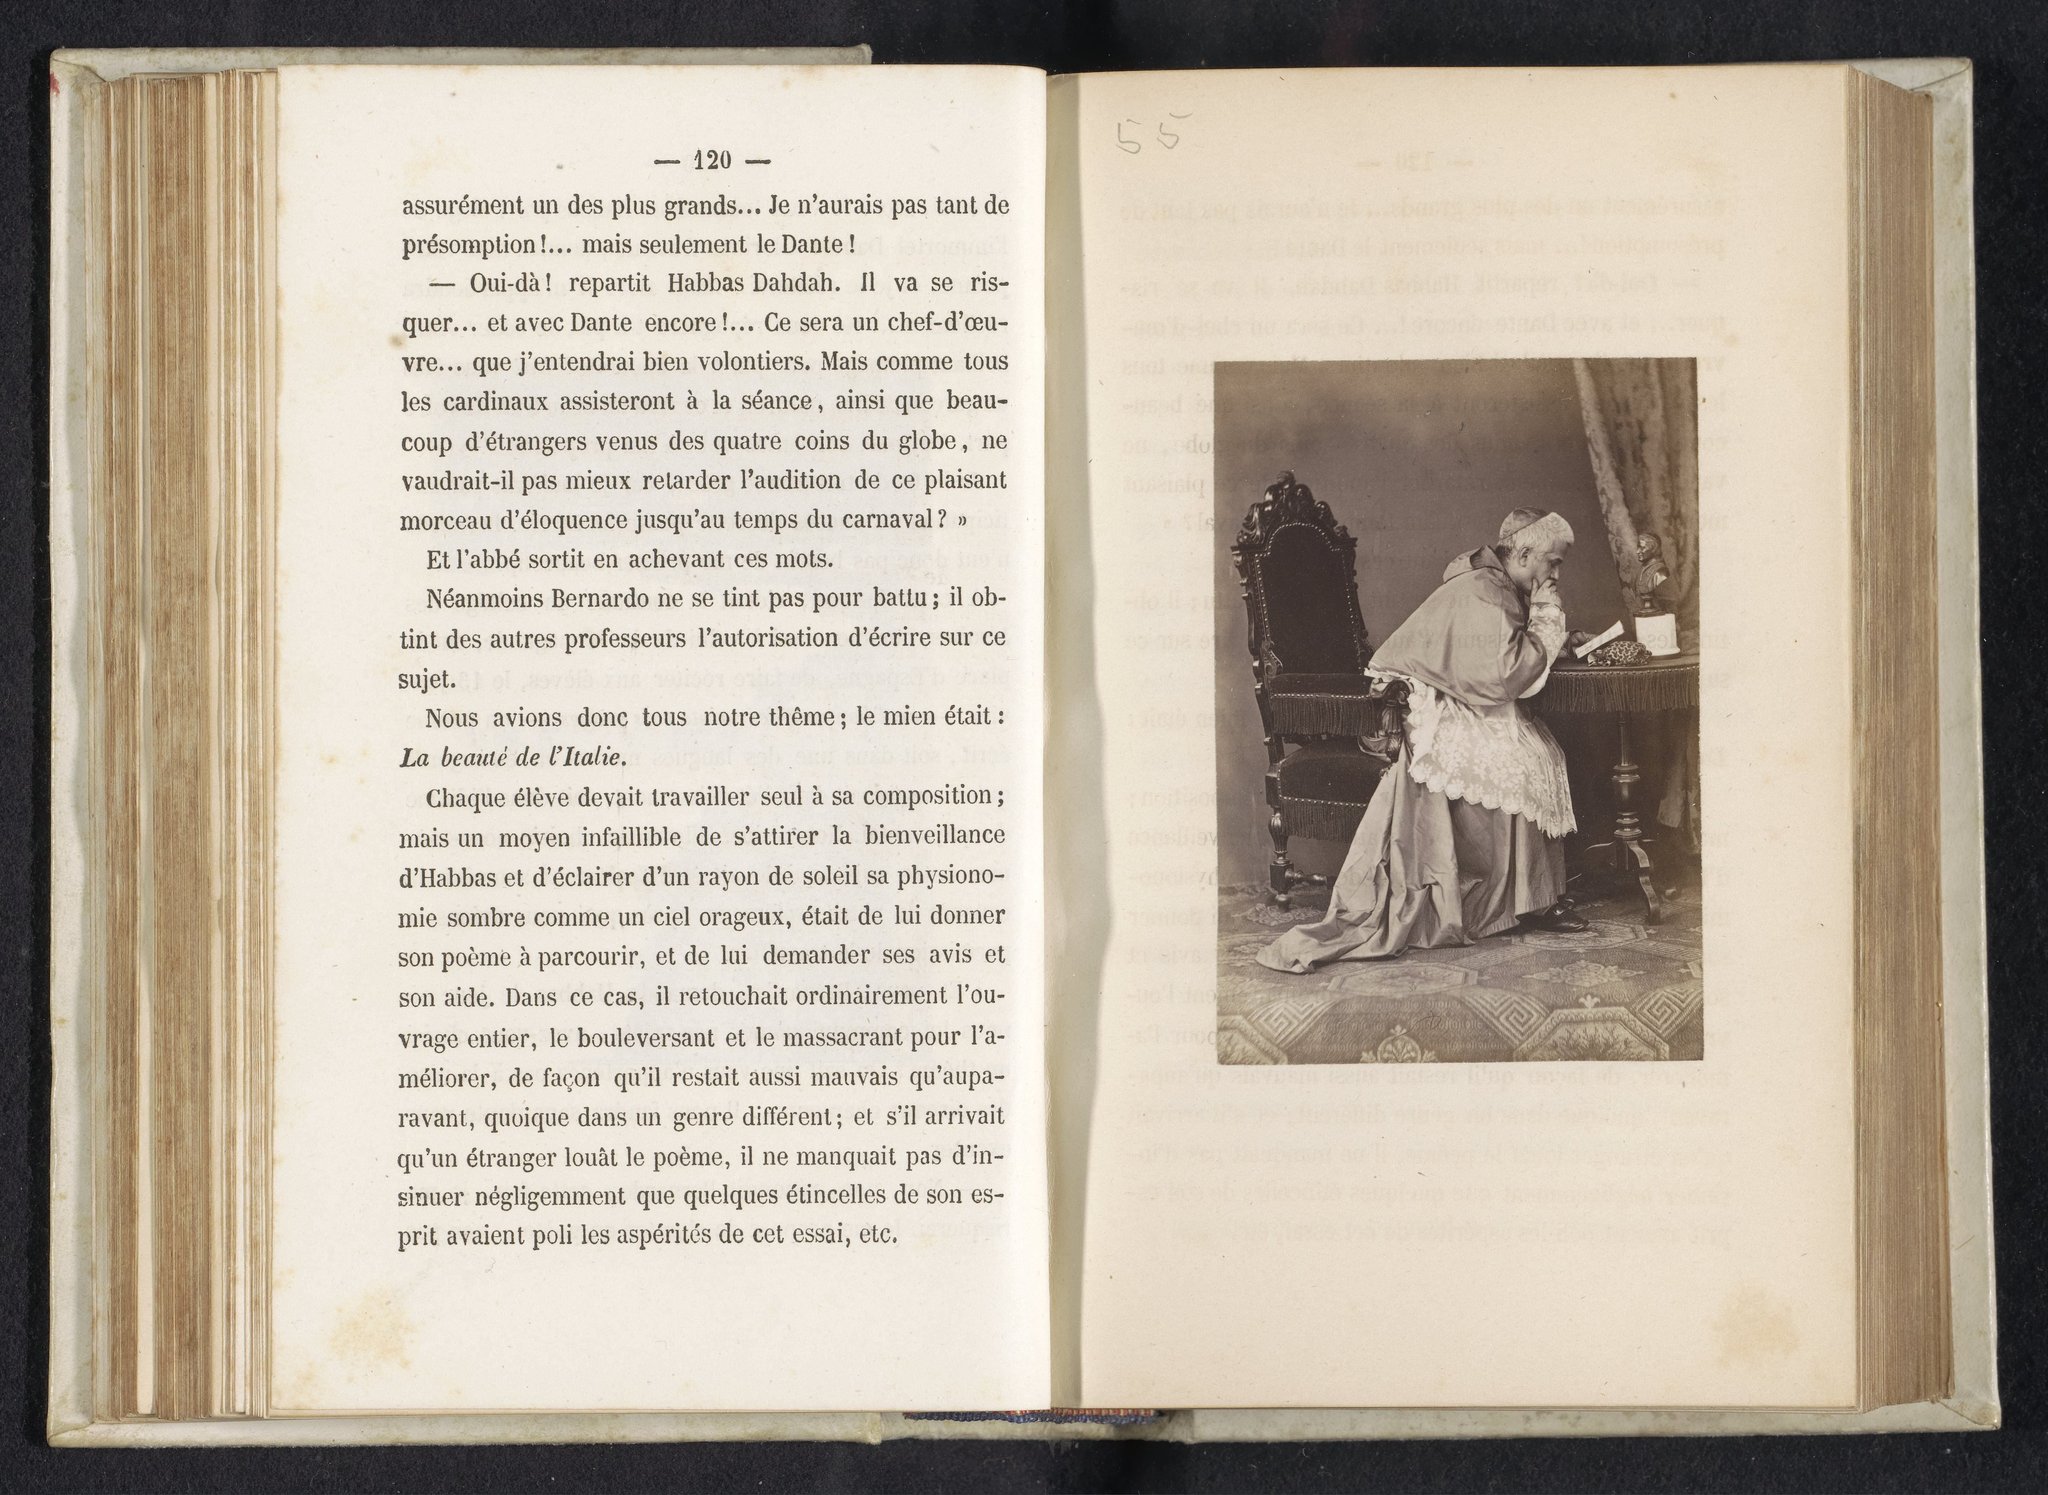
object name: page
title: Portret van een onbekende kardinaal in een interieur aan een schrijftafel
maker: Anonymous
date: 1850-1860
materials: photographic support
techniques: albumen print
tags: writing-table, writing-desk, cardinal, historical persons not known by name